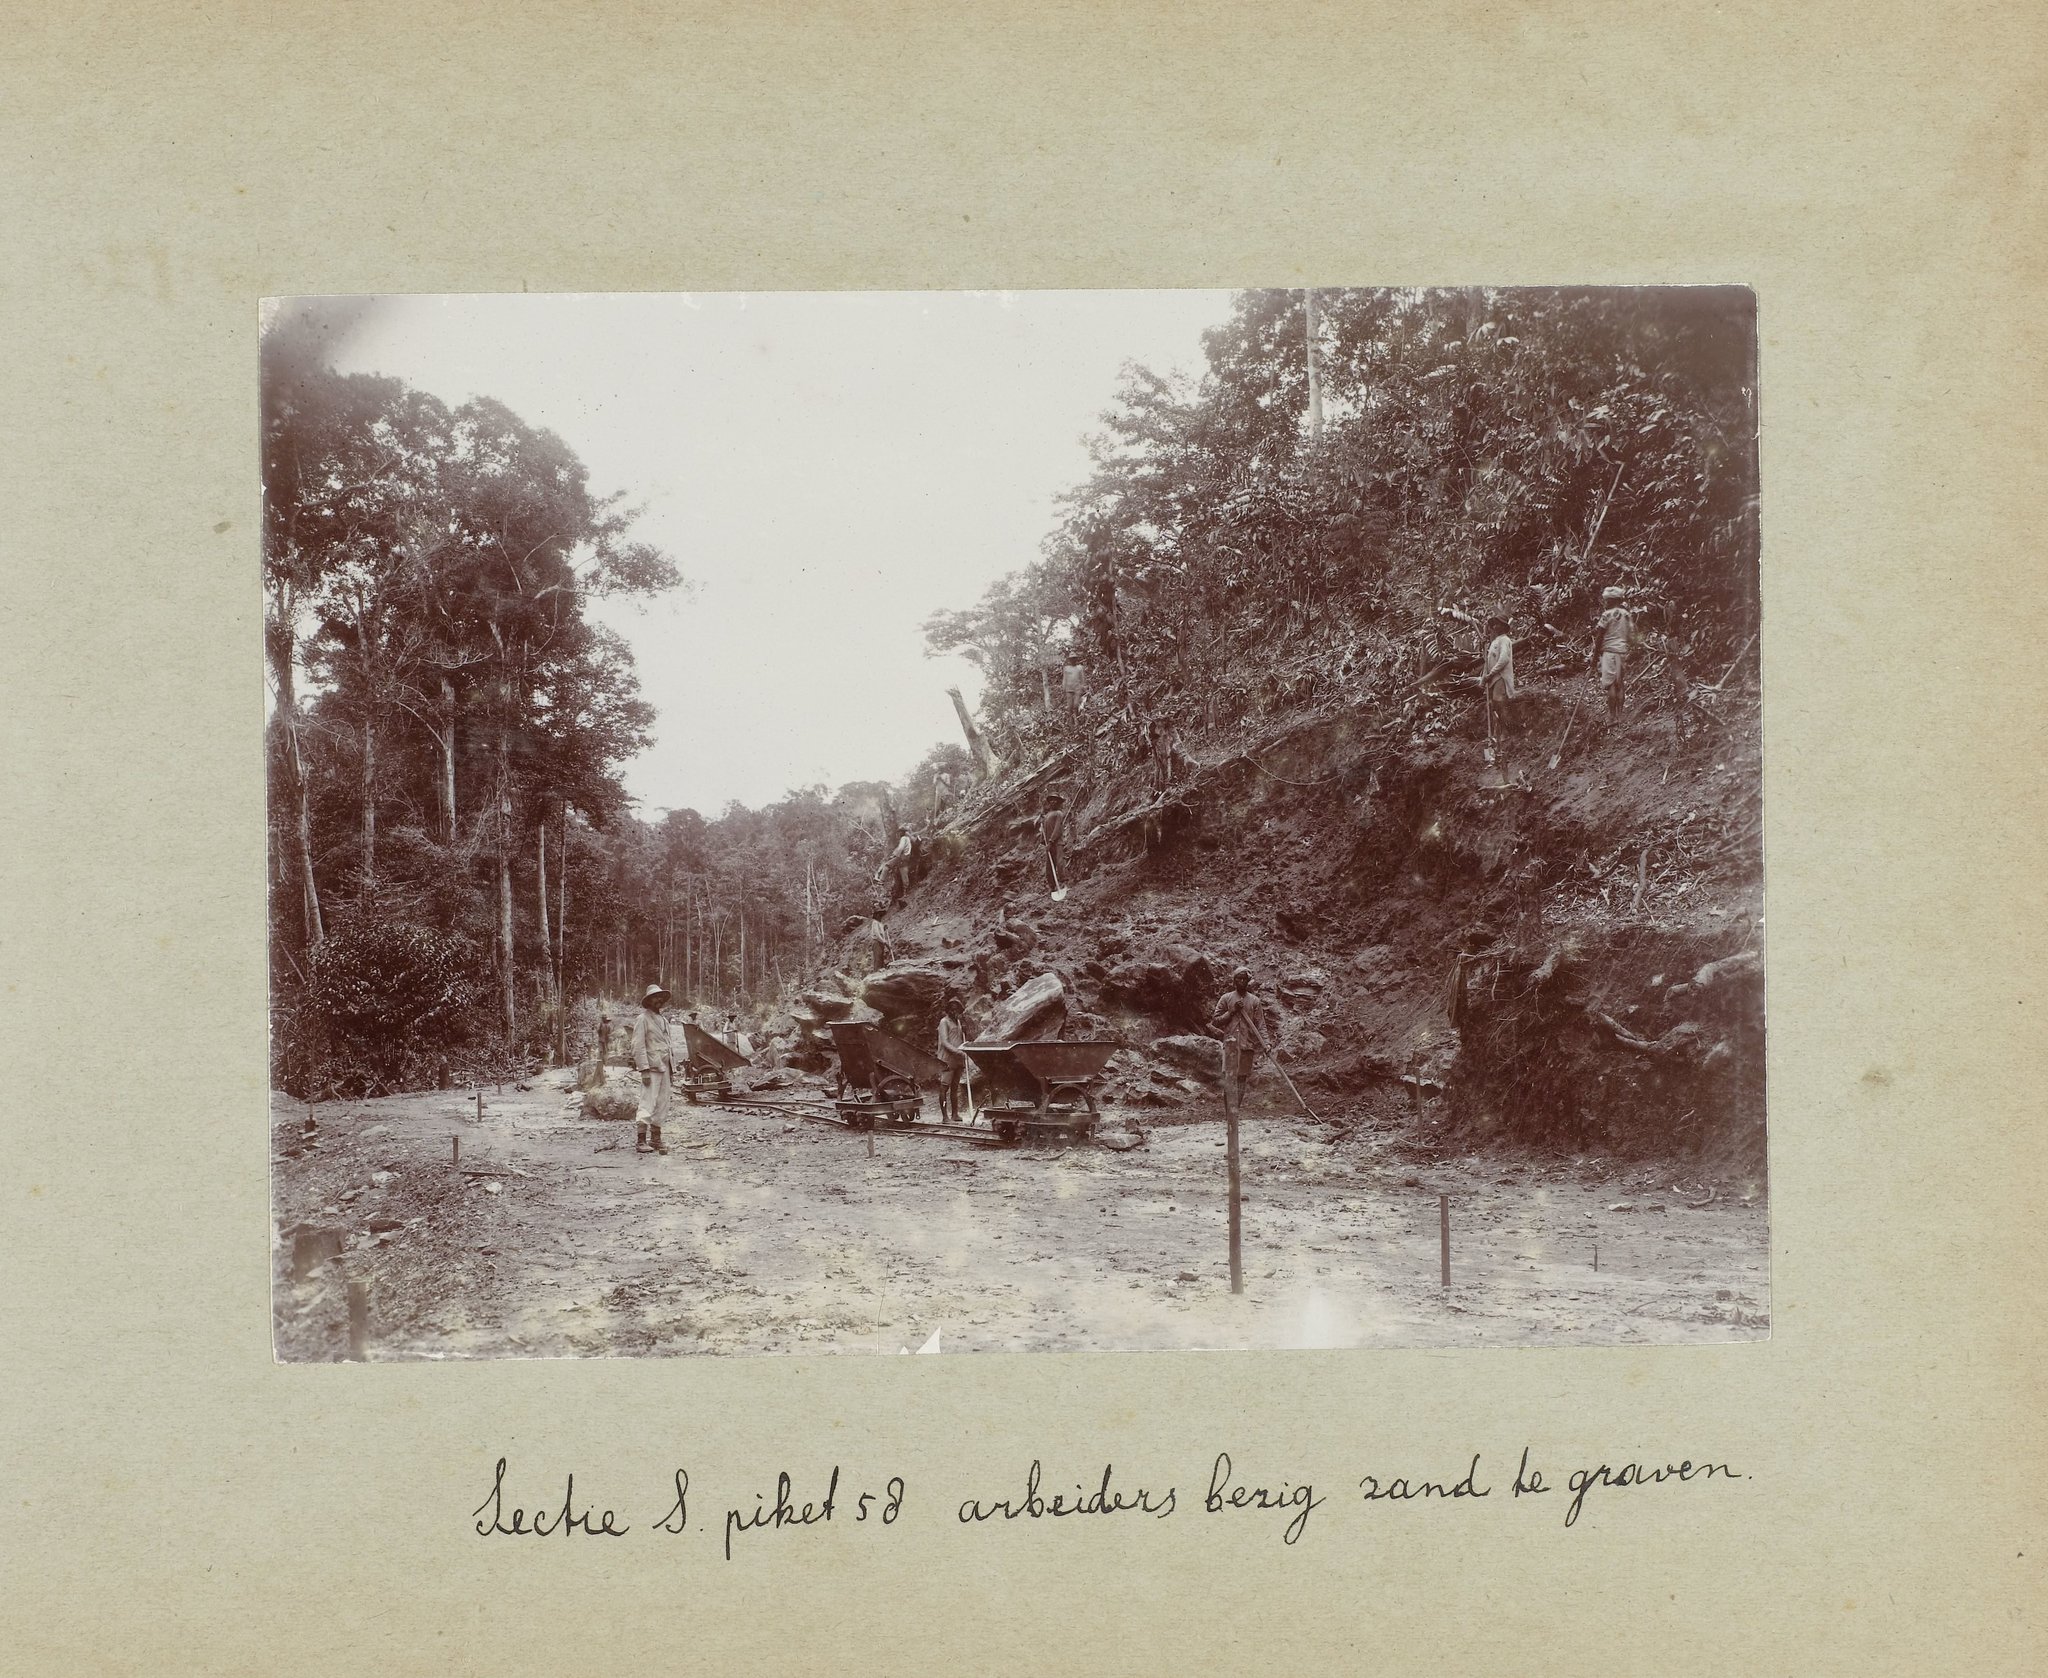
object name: photograph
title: Sectie S - piket 58 arbeiders bezig zand te graven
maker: augusta curiel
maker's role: fotograaf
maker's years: 1873-1937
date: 1905-1910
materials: photographic support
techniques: photography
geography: suriname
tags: jacob evert wesenhagen, railway, tramway; rack railway, suriname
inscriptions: inscription: ‘Sectie S - piket 58 arbeiders bezig zand te graven’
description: Grondwerkzaamheden in sectie S. Arbeiders zijn bezig zand te graven. Foto in het fotoalbum over de aanleg van de Lawaspoorweg in Suriname in de jaren 1903-1912. Onderdeel van een groep objecten afkomstig van de familie Wesenhagen in Suriname.